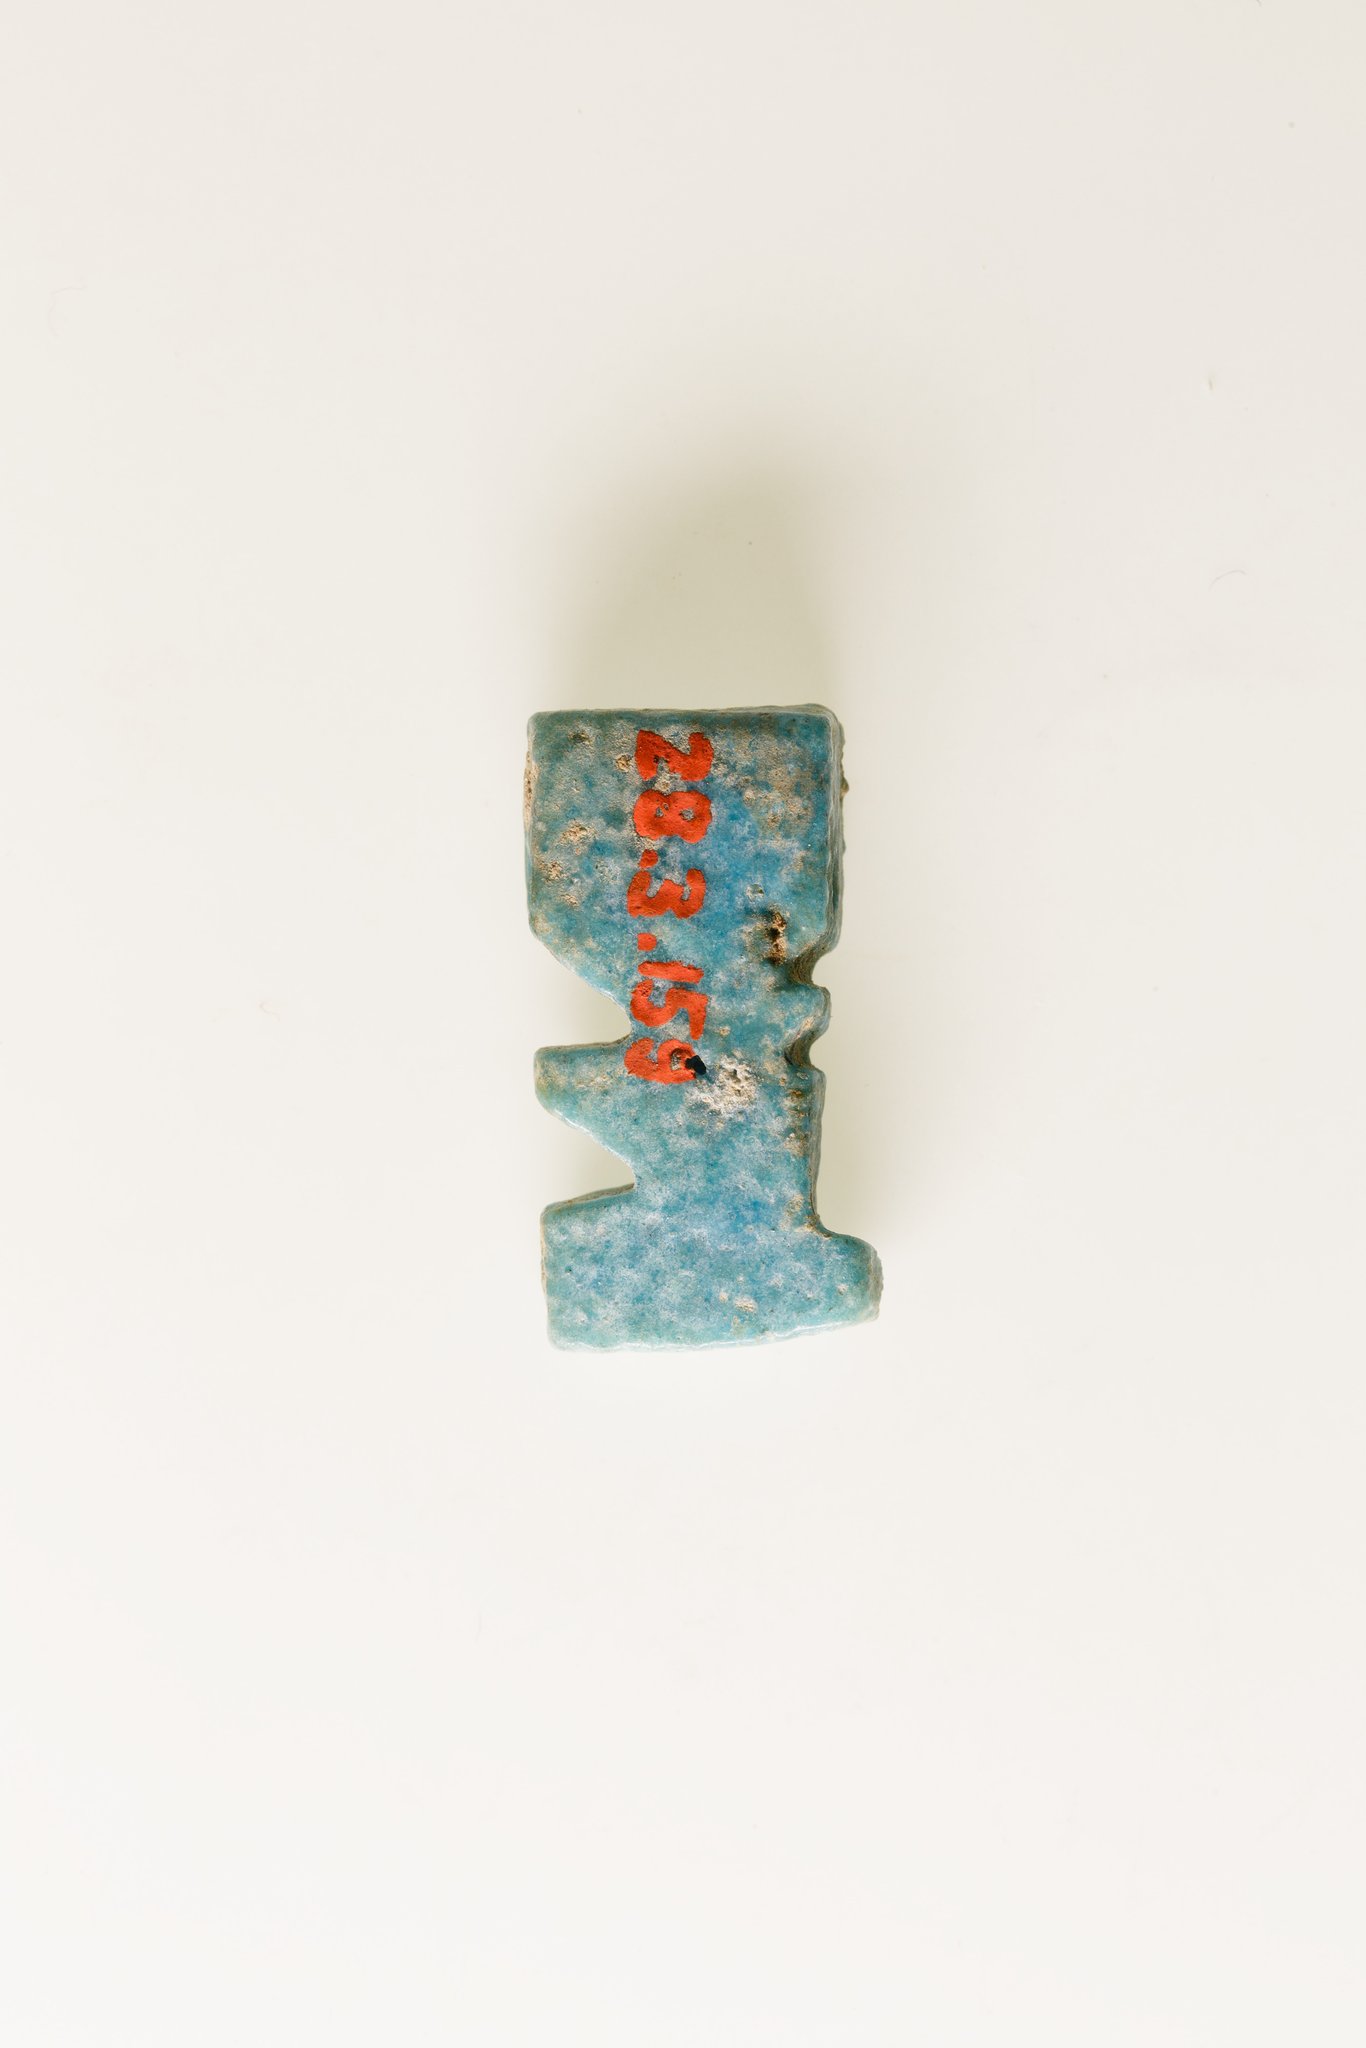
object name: amulet, shu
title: Shu amulet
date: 712-332 BCE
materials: faience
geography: egypt